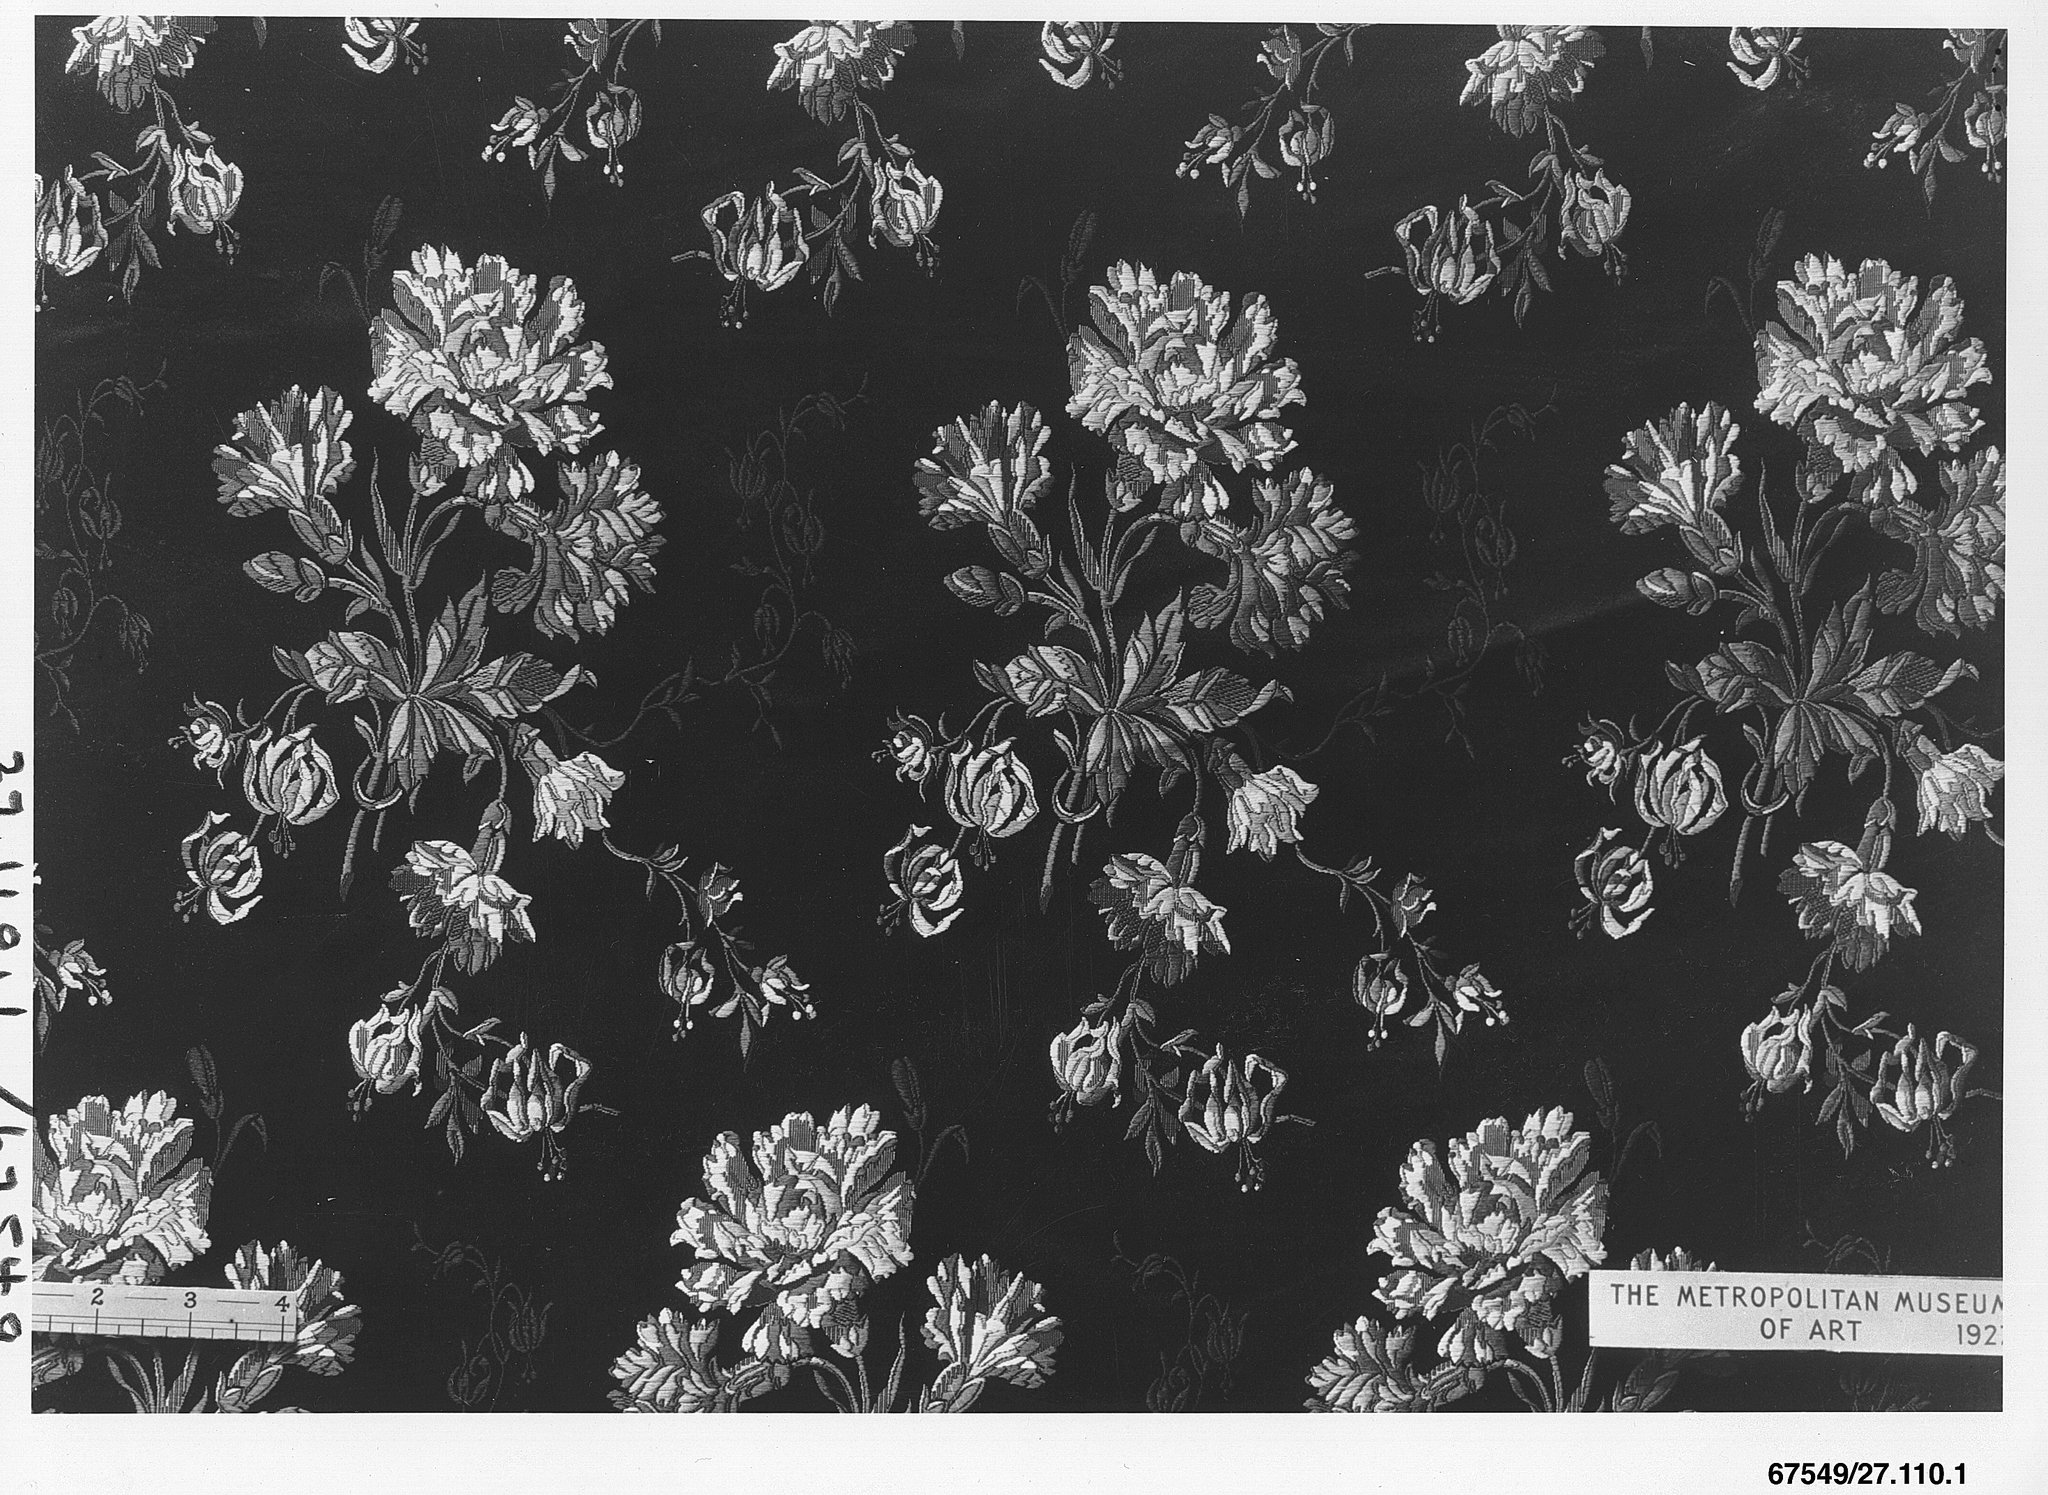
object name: fragment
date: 1850-1875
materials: silk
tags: flowers,leaves